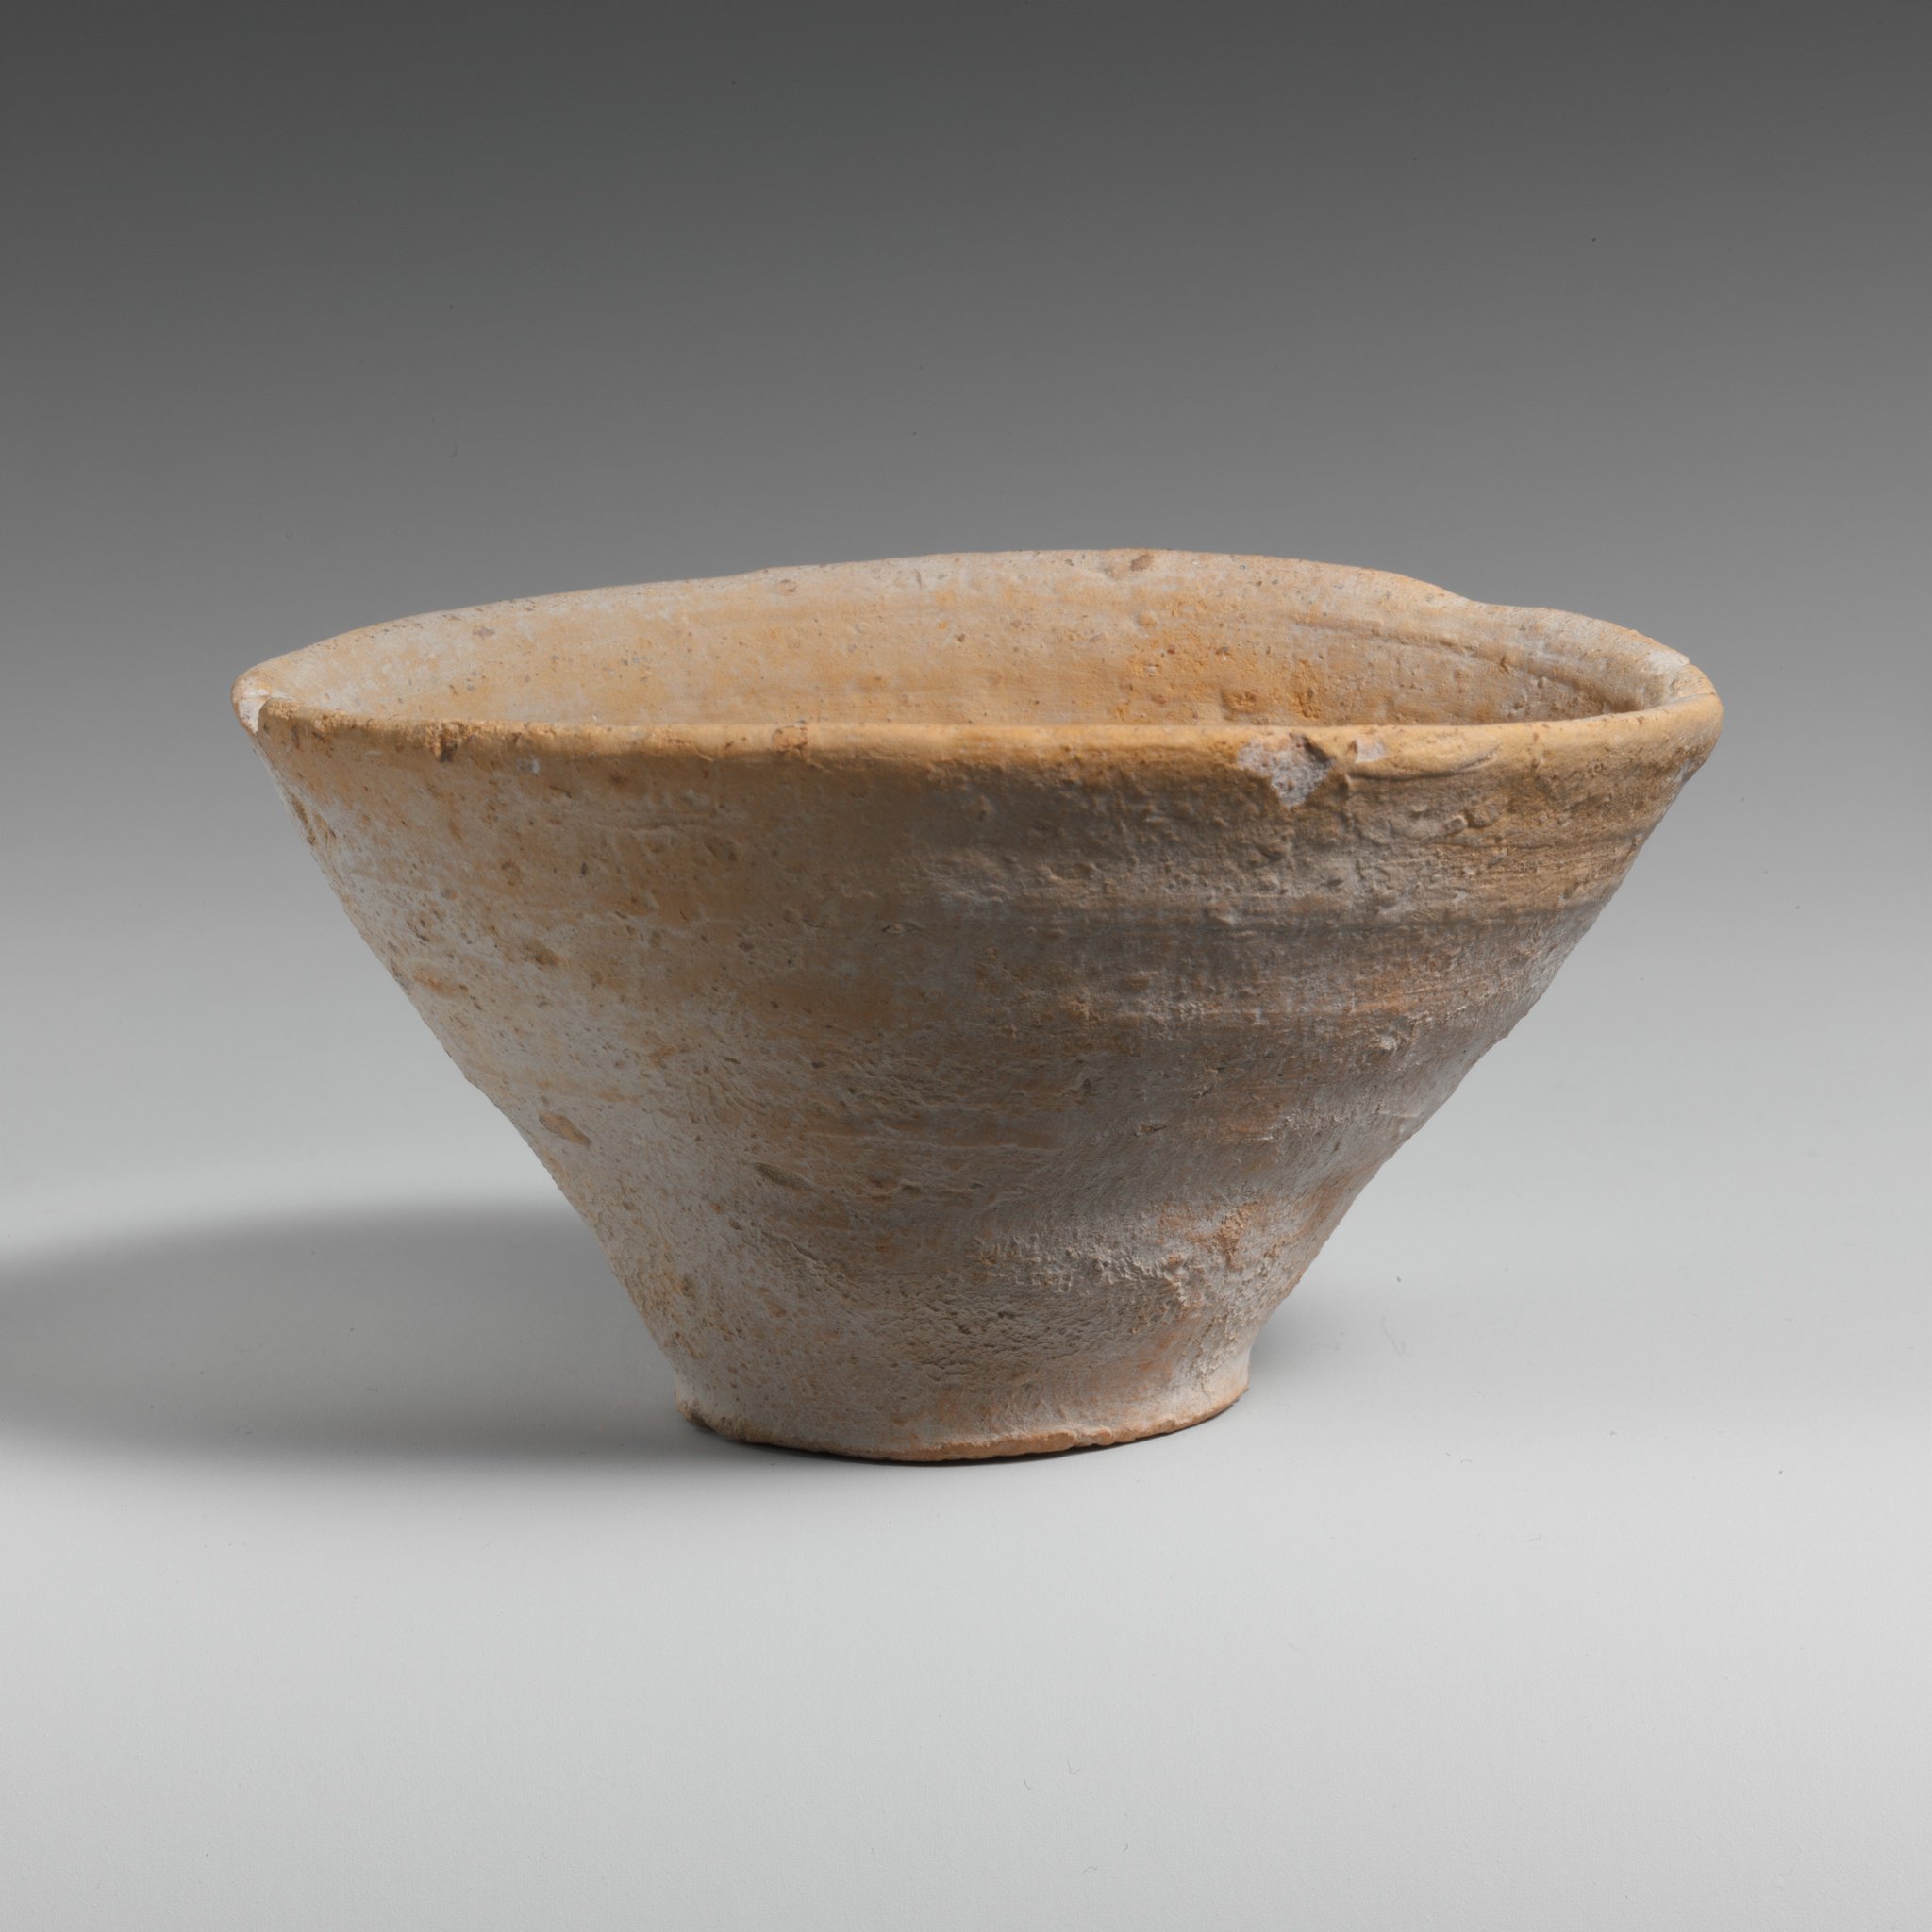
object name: bowl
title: Terracotta conical cup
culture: minoan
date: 1750-1700 BCE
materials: terracotta